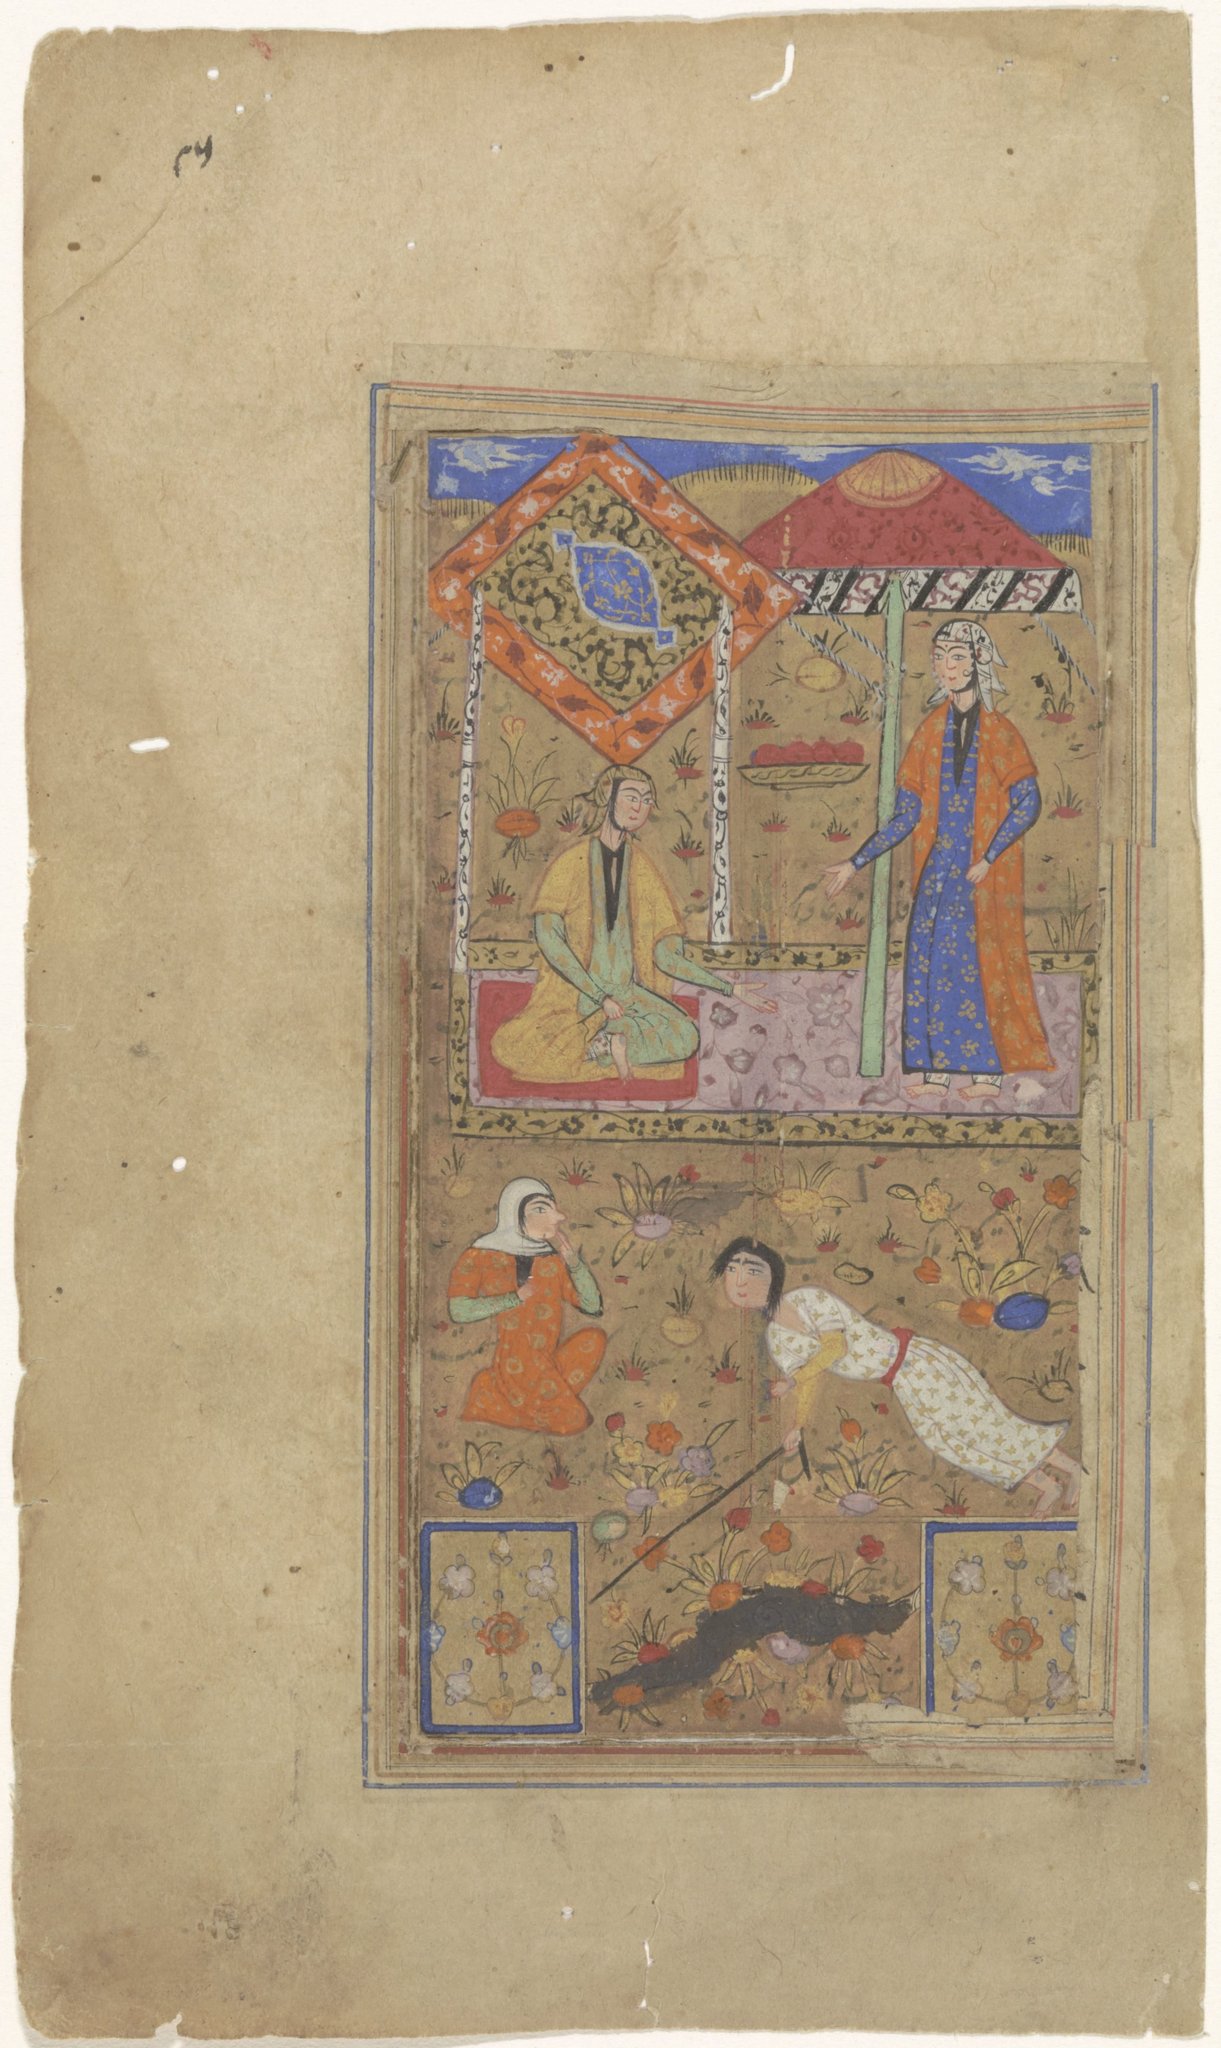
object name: drawing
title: Vrouw onder een baldakijn en een vrouw op haar knieën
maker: Anonymous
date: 1500-1800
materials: paper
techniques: brush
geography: iran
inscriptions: inscription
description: De voorstelling is in twee vlakken verdeeld: in het bovenste vlak zit een vrouw onder een baldakijn en een tweede vrouw staat tegenover haar, in het onderste vlak zit een vrouw op haar knieën en houdt haar linkerhand voor haar mond, tegenover haar ligt een in het wit geklede man diagonaal door het vlak en houdt een soort staf in zijn rechterhand. De voorstelling is in een raamwerk van kaderlijntjes geplakt, waarvan de oude randen hier en daar zijn losgegaan en nieuwe randjes overheen zijn geplakt; de buitenrand is onversierd en ligt aan de onder-, boven- en linkerkant van de voorstelling.